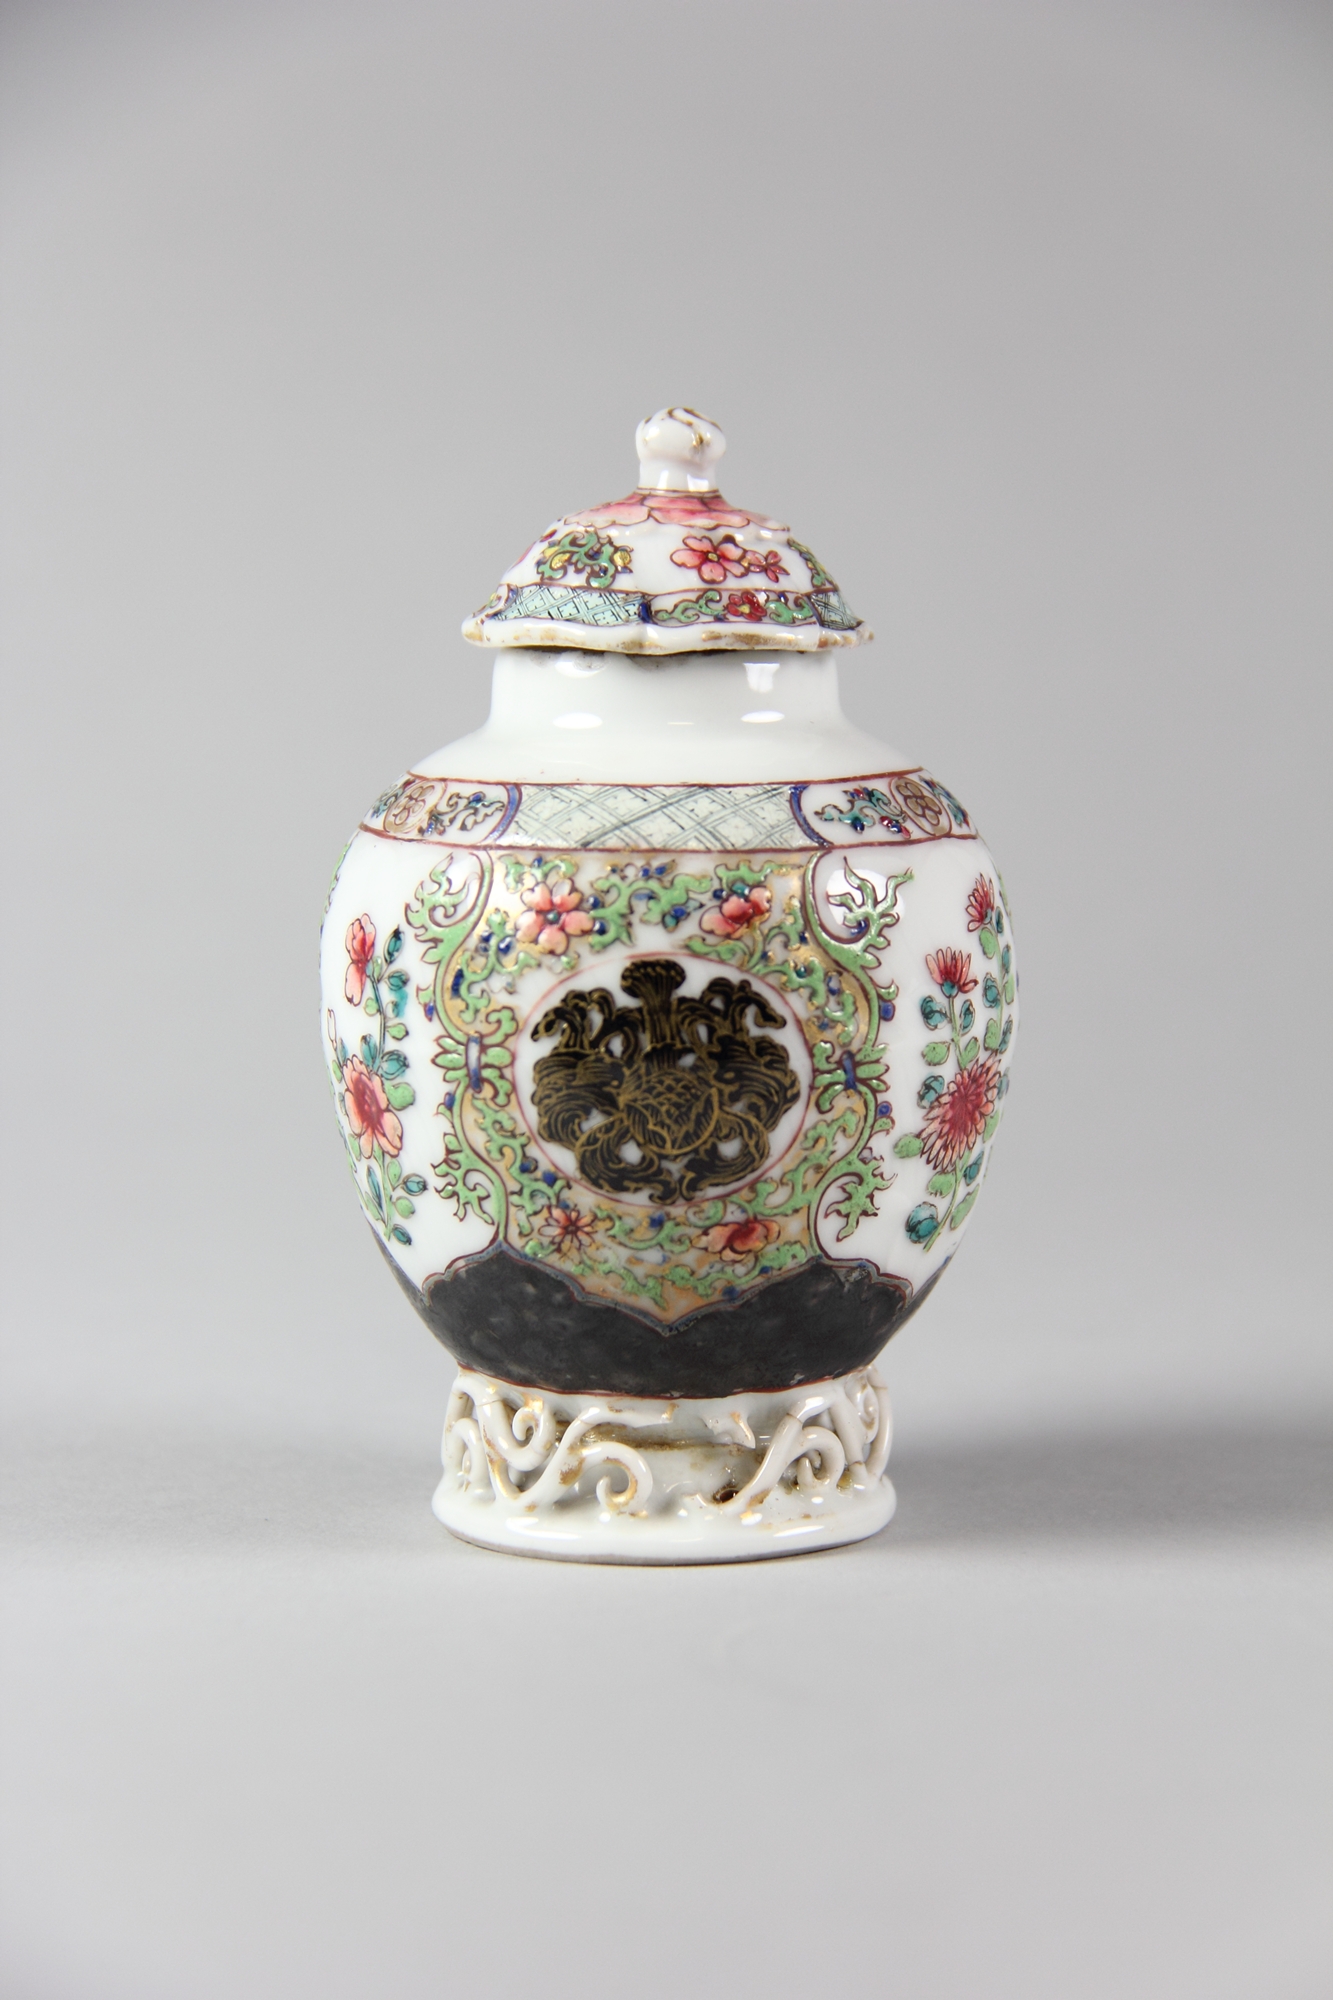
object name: covered jar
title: Covered jar with floral pattern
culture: chinese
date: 1767-1800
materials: enamel, porcelain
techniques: overglaze, painting, polychrome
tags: flowers